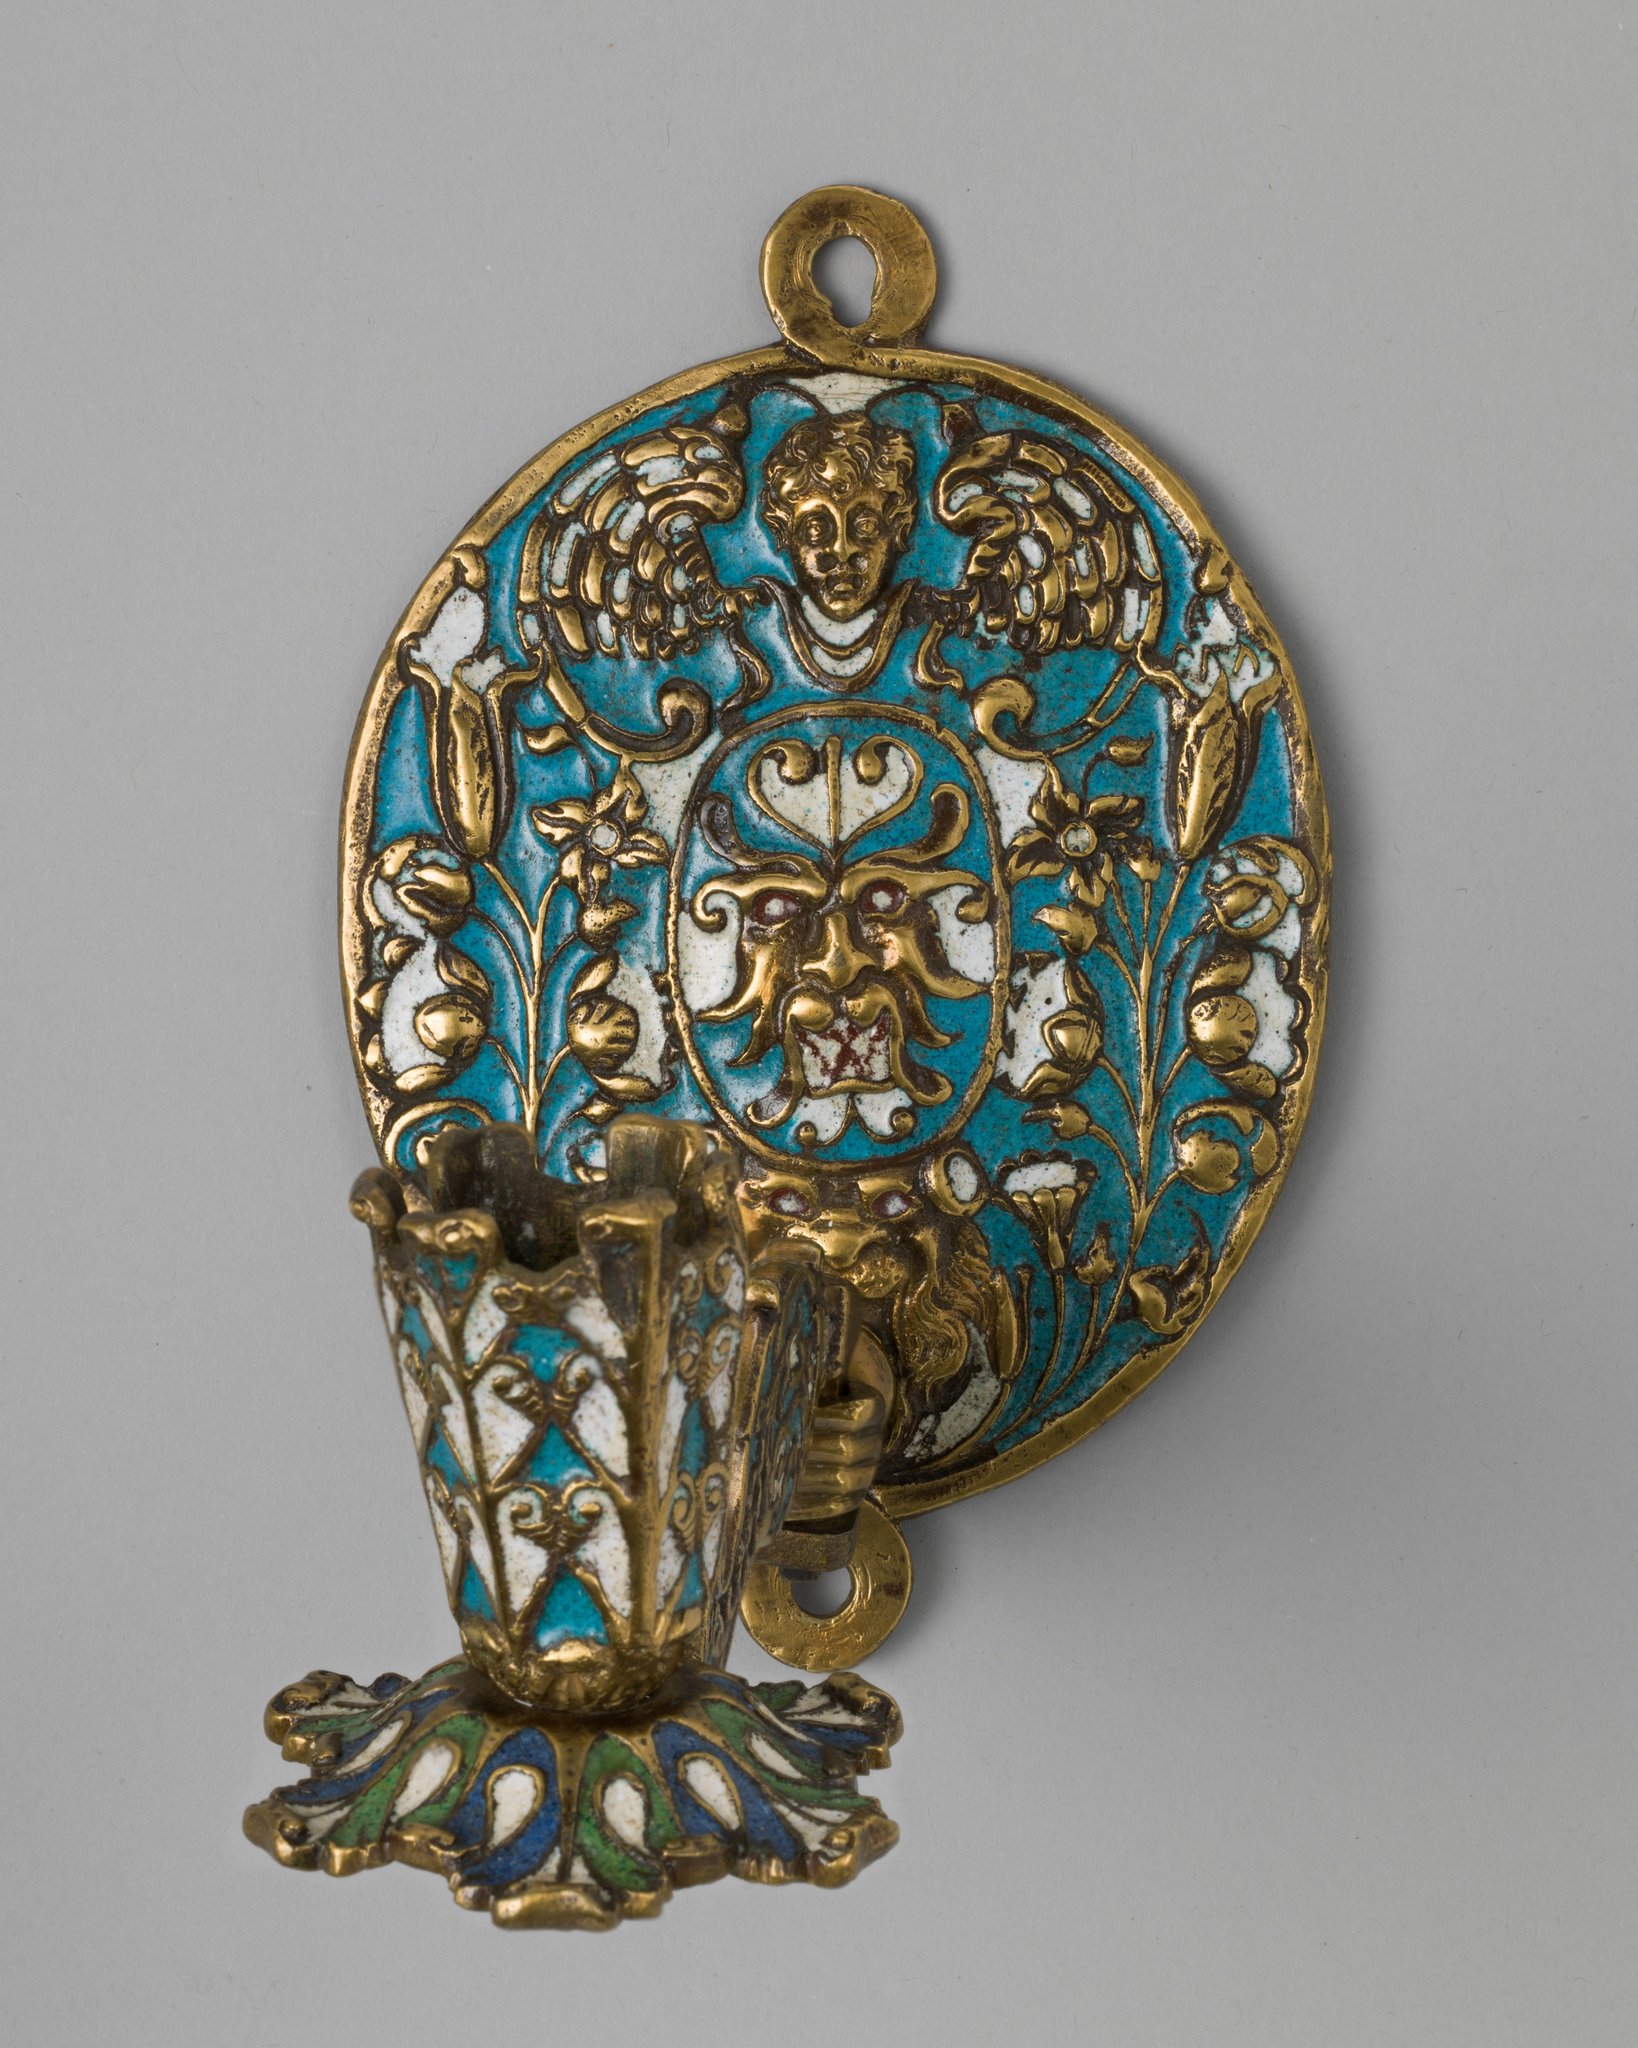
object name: sconce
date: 1601-1700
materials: brass, enamel